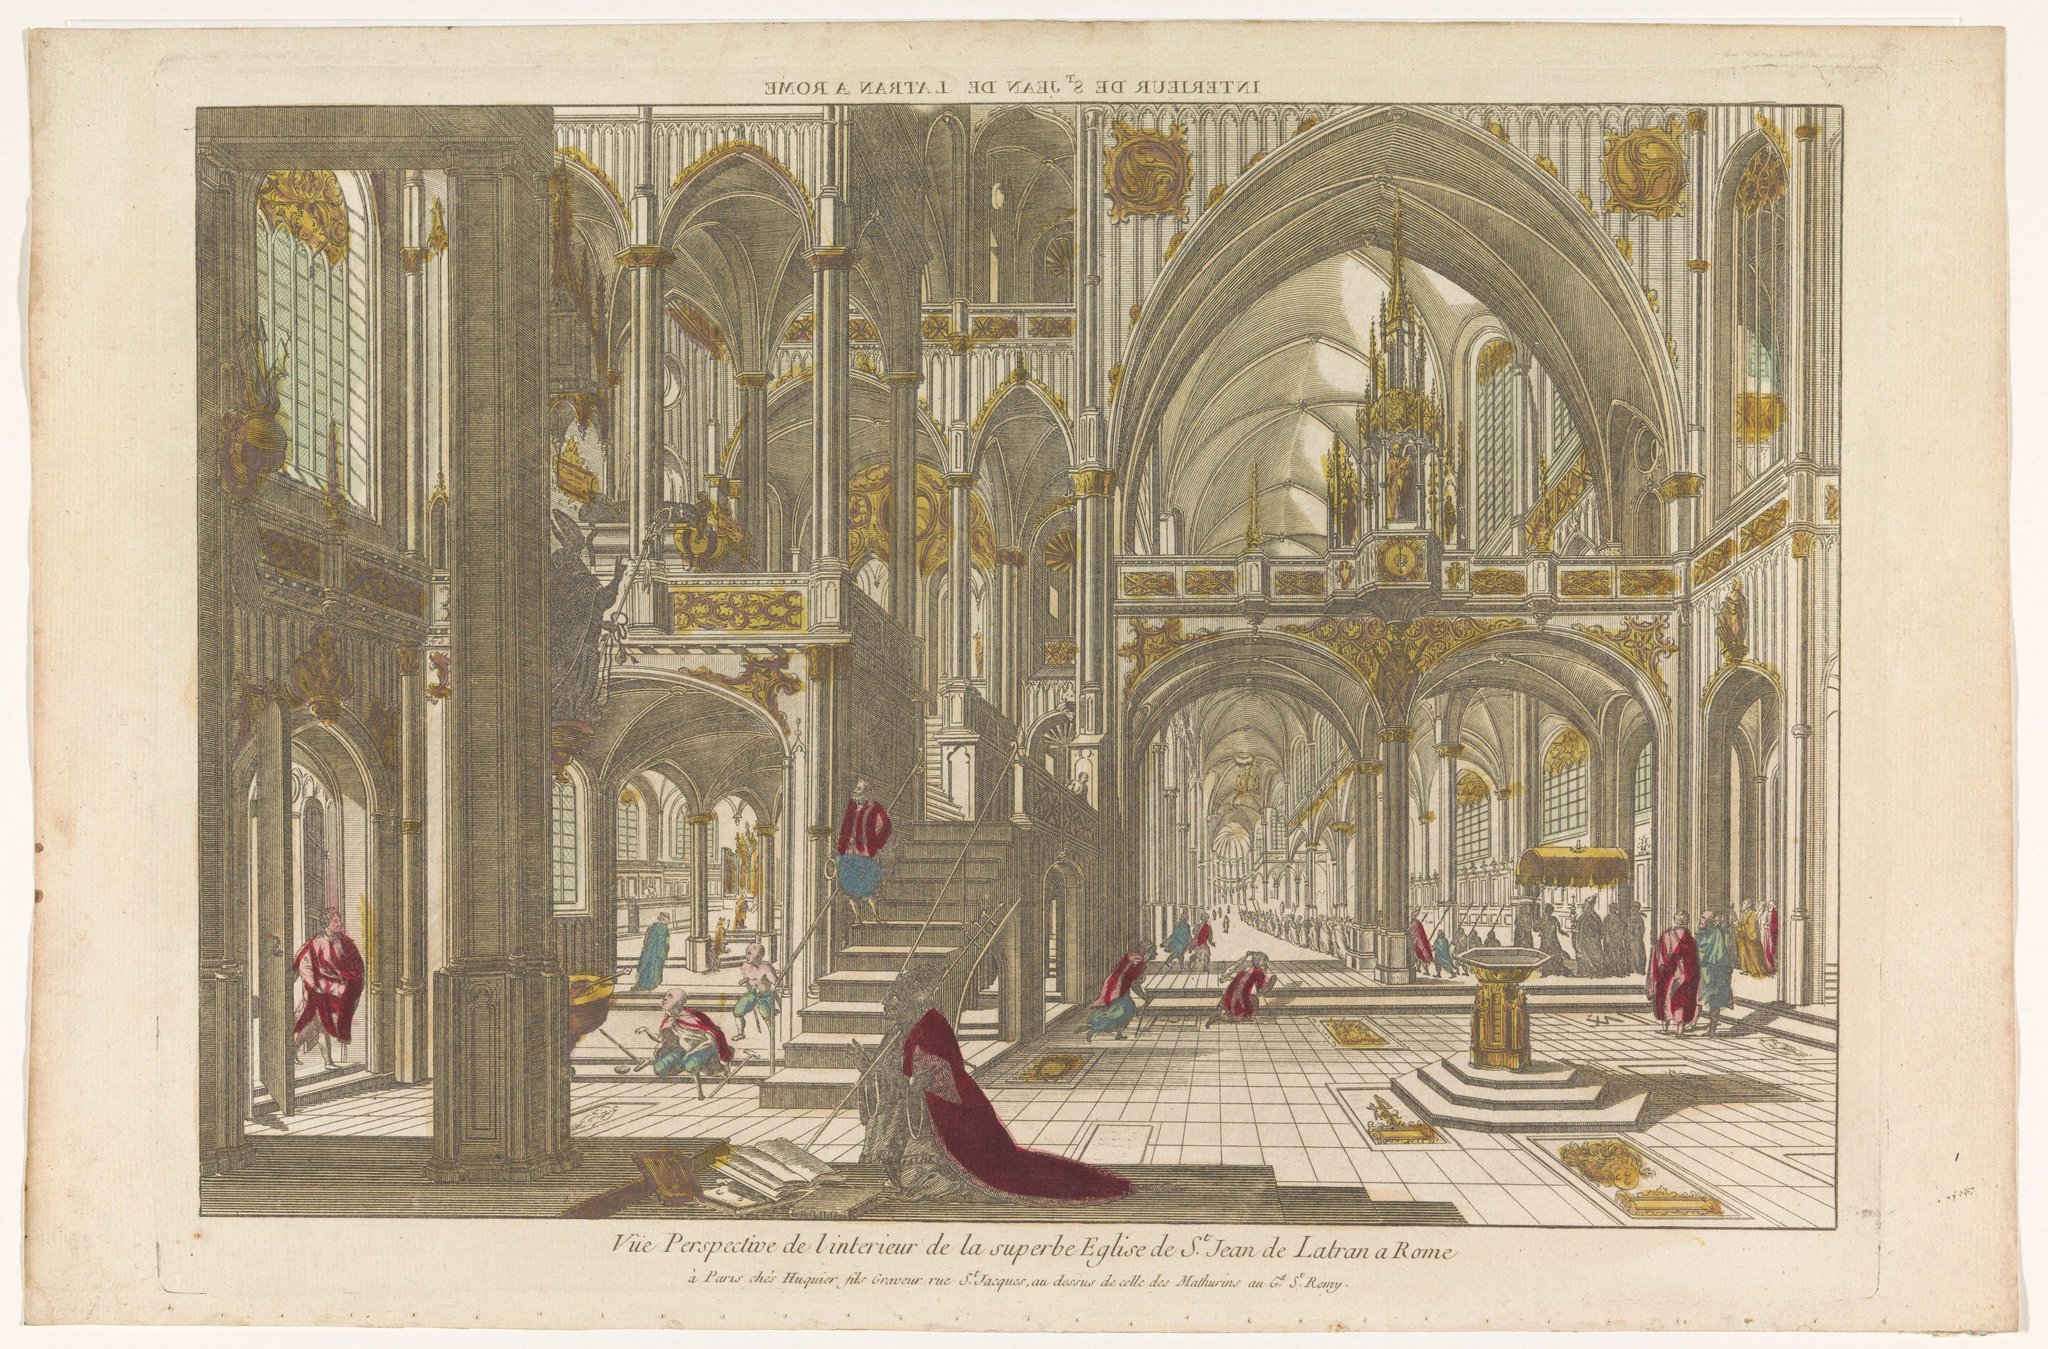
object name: print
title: Interieur de St Jean de Latran a Rome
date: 1735-1805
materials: paper, watercolor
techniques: brush, etching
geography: paris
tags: interior of church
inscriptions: collector's mark: Lugt 2166